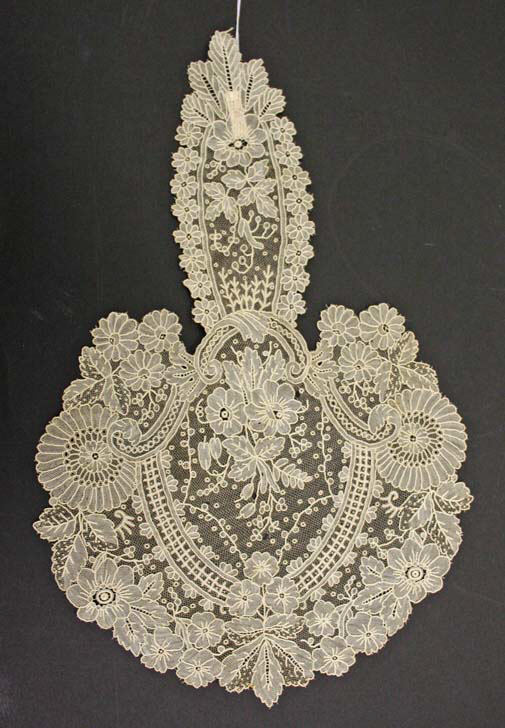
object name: cap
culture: belgian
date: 1860-1880